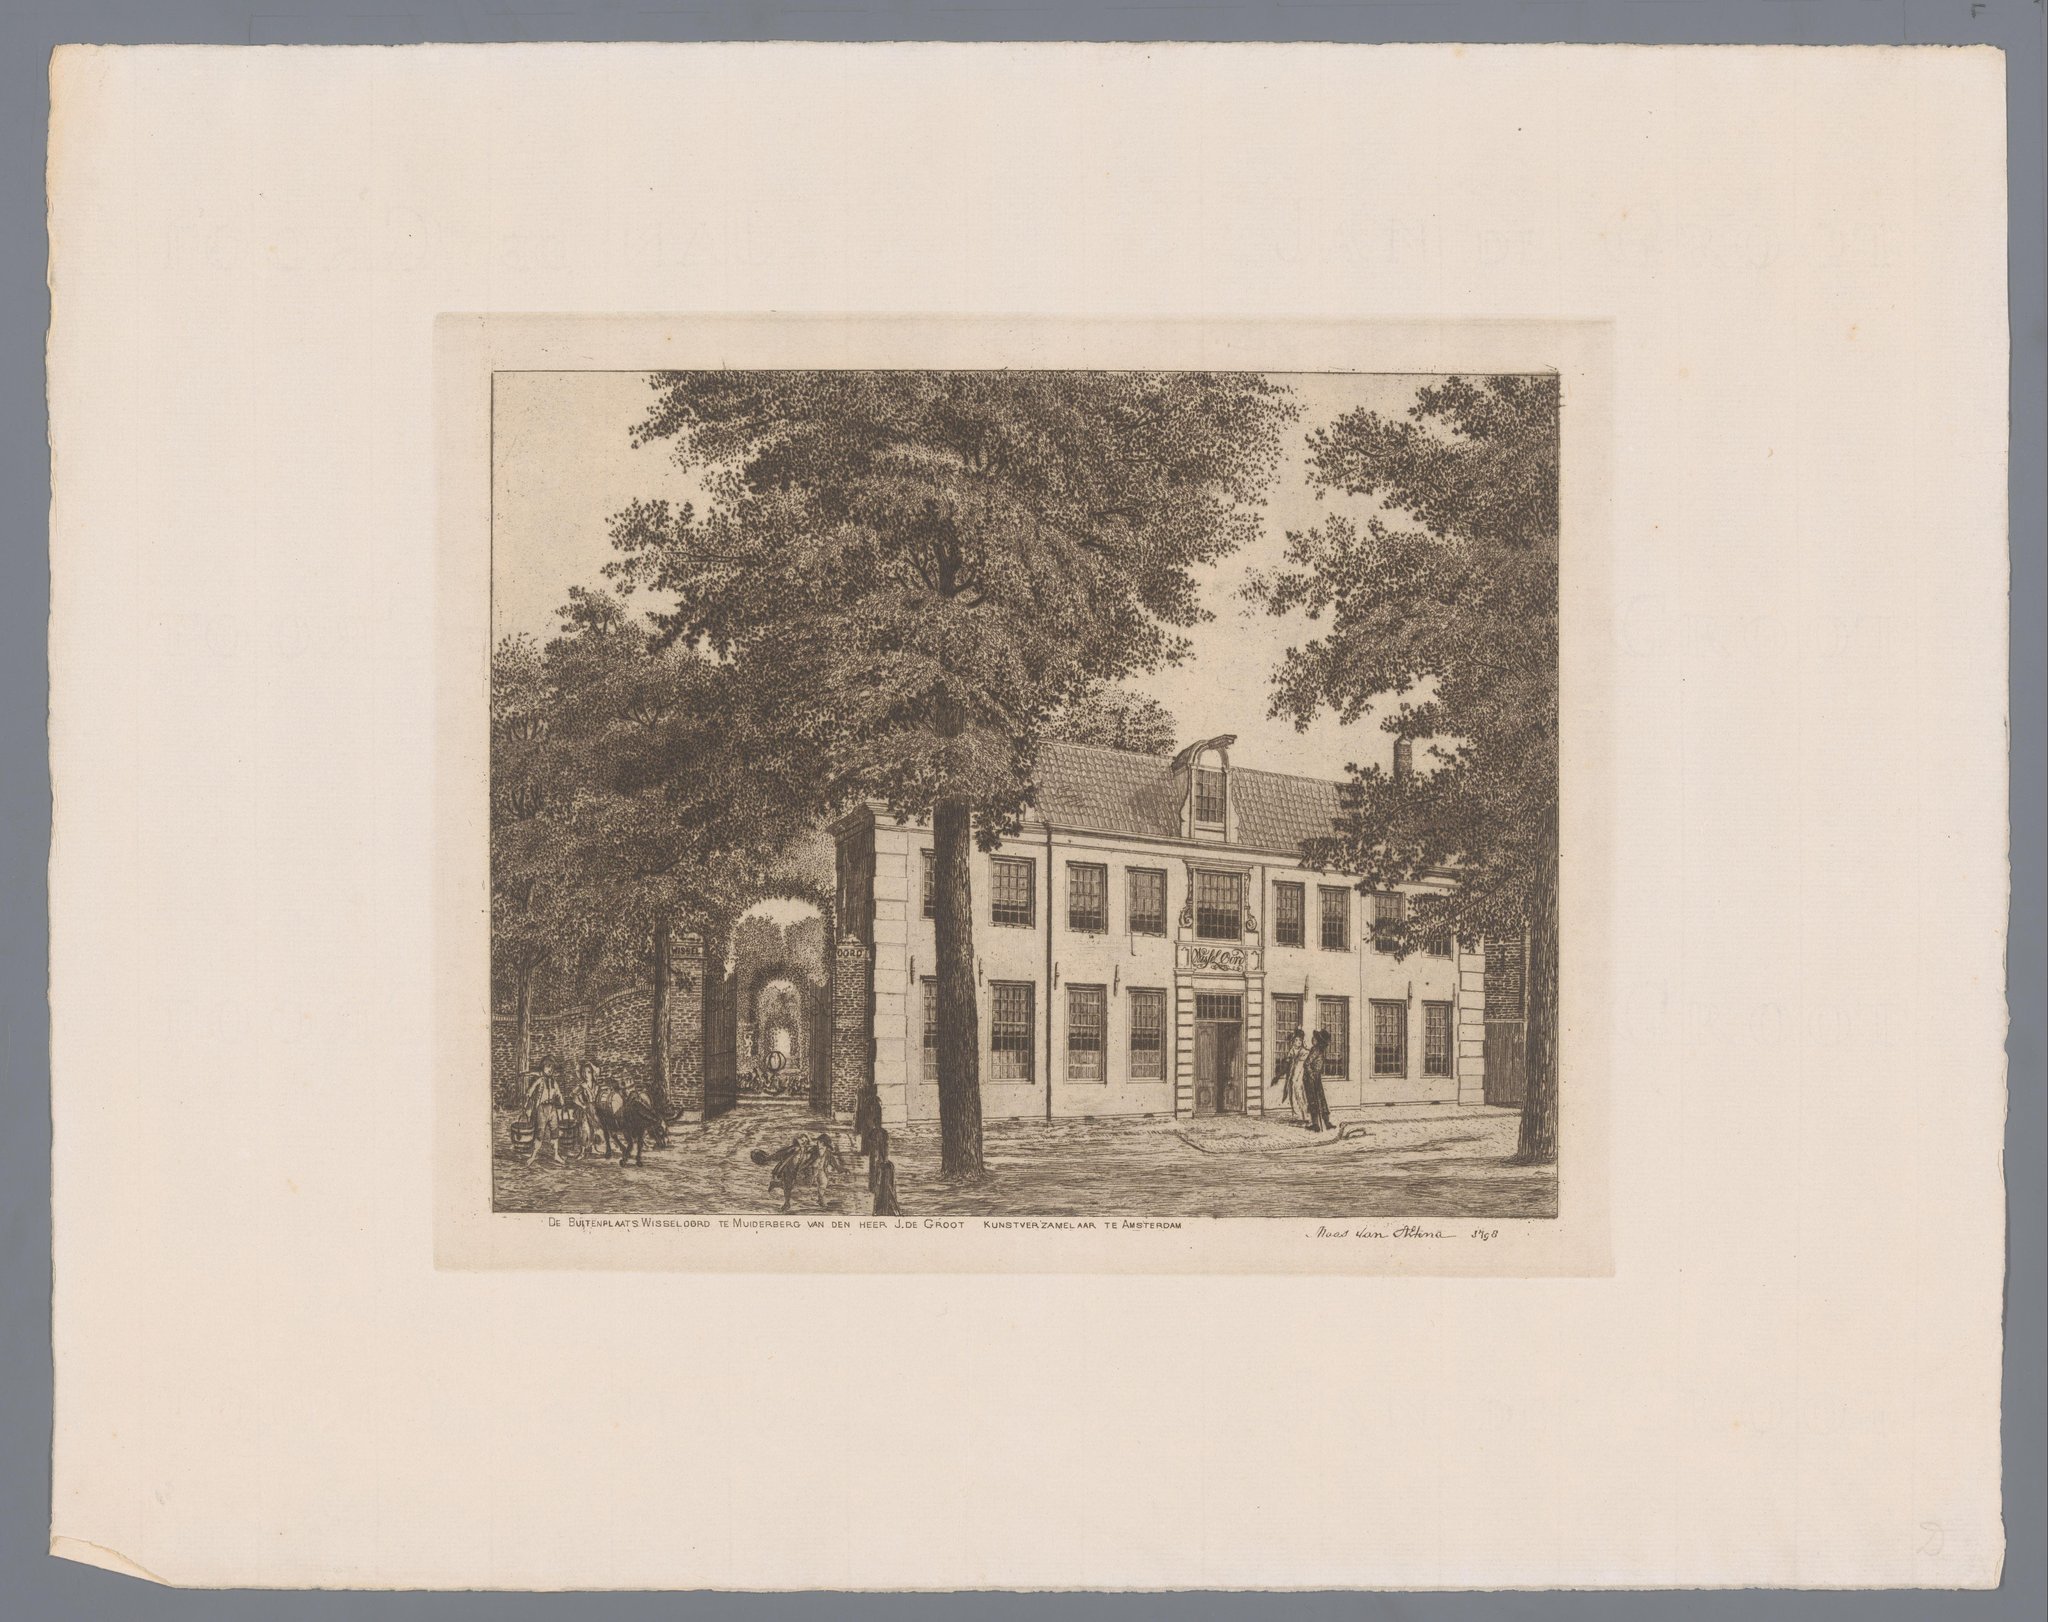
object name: print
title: De Buitenplaats Wisseloord te Muiderberg van den heer J. de Groot kunstverzamelaar te Amsterdam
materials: paper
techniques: etching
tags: rural housing, e.g. country-house, villa, cottage